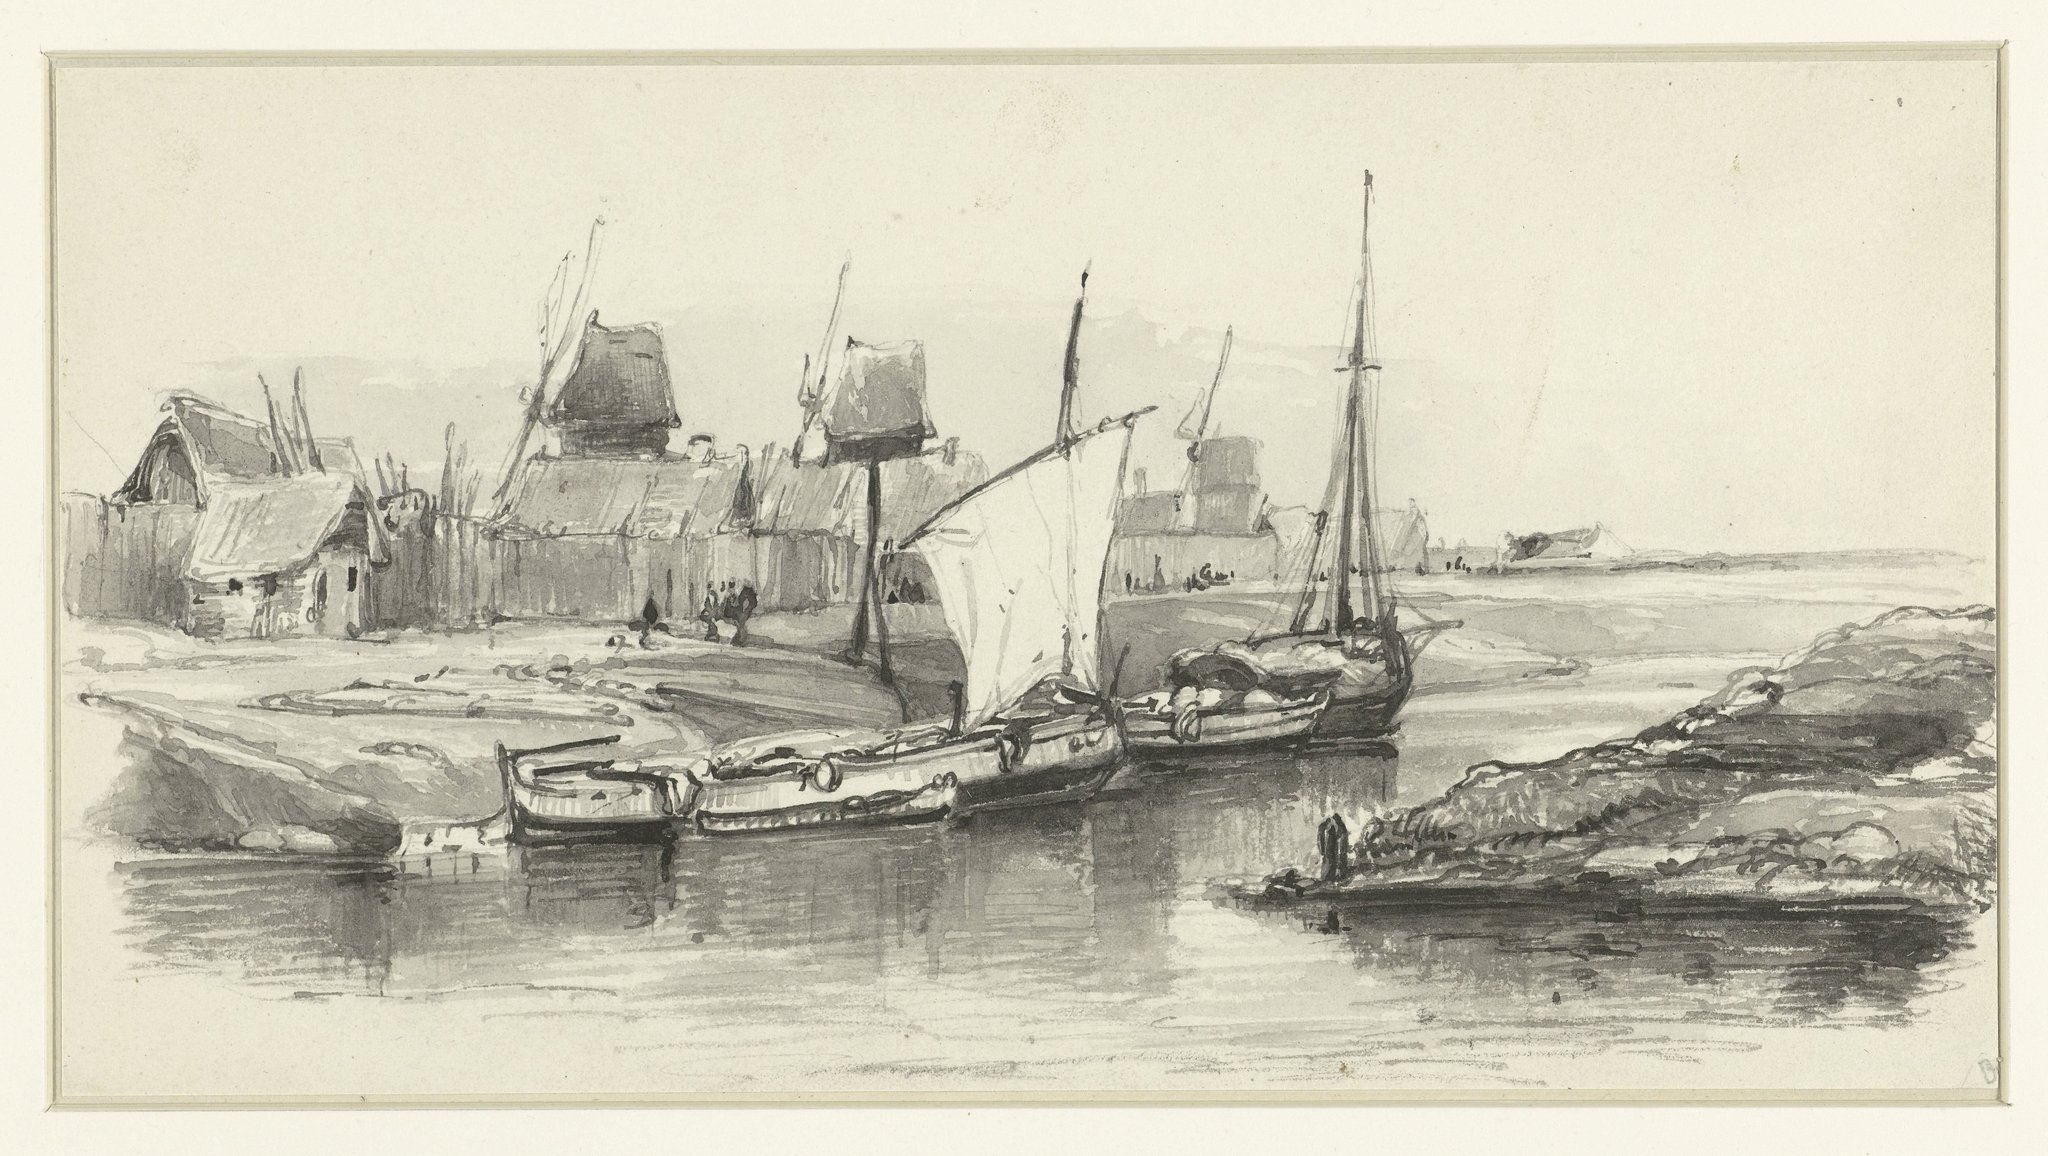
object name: drawing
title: Gezicht in een Franse of Belgische kustplaats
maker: Anonymous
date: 1800-1900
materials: ink, paper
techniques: brush, pen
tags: sailing-ship, sailing-boat, windmill in landscape, windmill, prospect of village, silhouette of village (+ city(-scape) with figures, staffage)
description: In een smal kanaal, dat schuin naar de achtergrond loopt, liggen drie scheepjes gemeerd. Langs de linkeroever van het kanaal loopt een lange weg met armoedige huisjes, waarboven drie windmolens uitsteken.